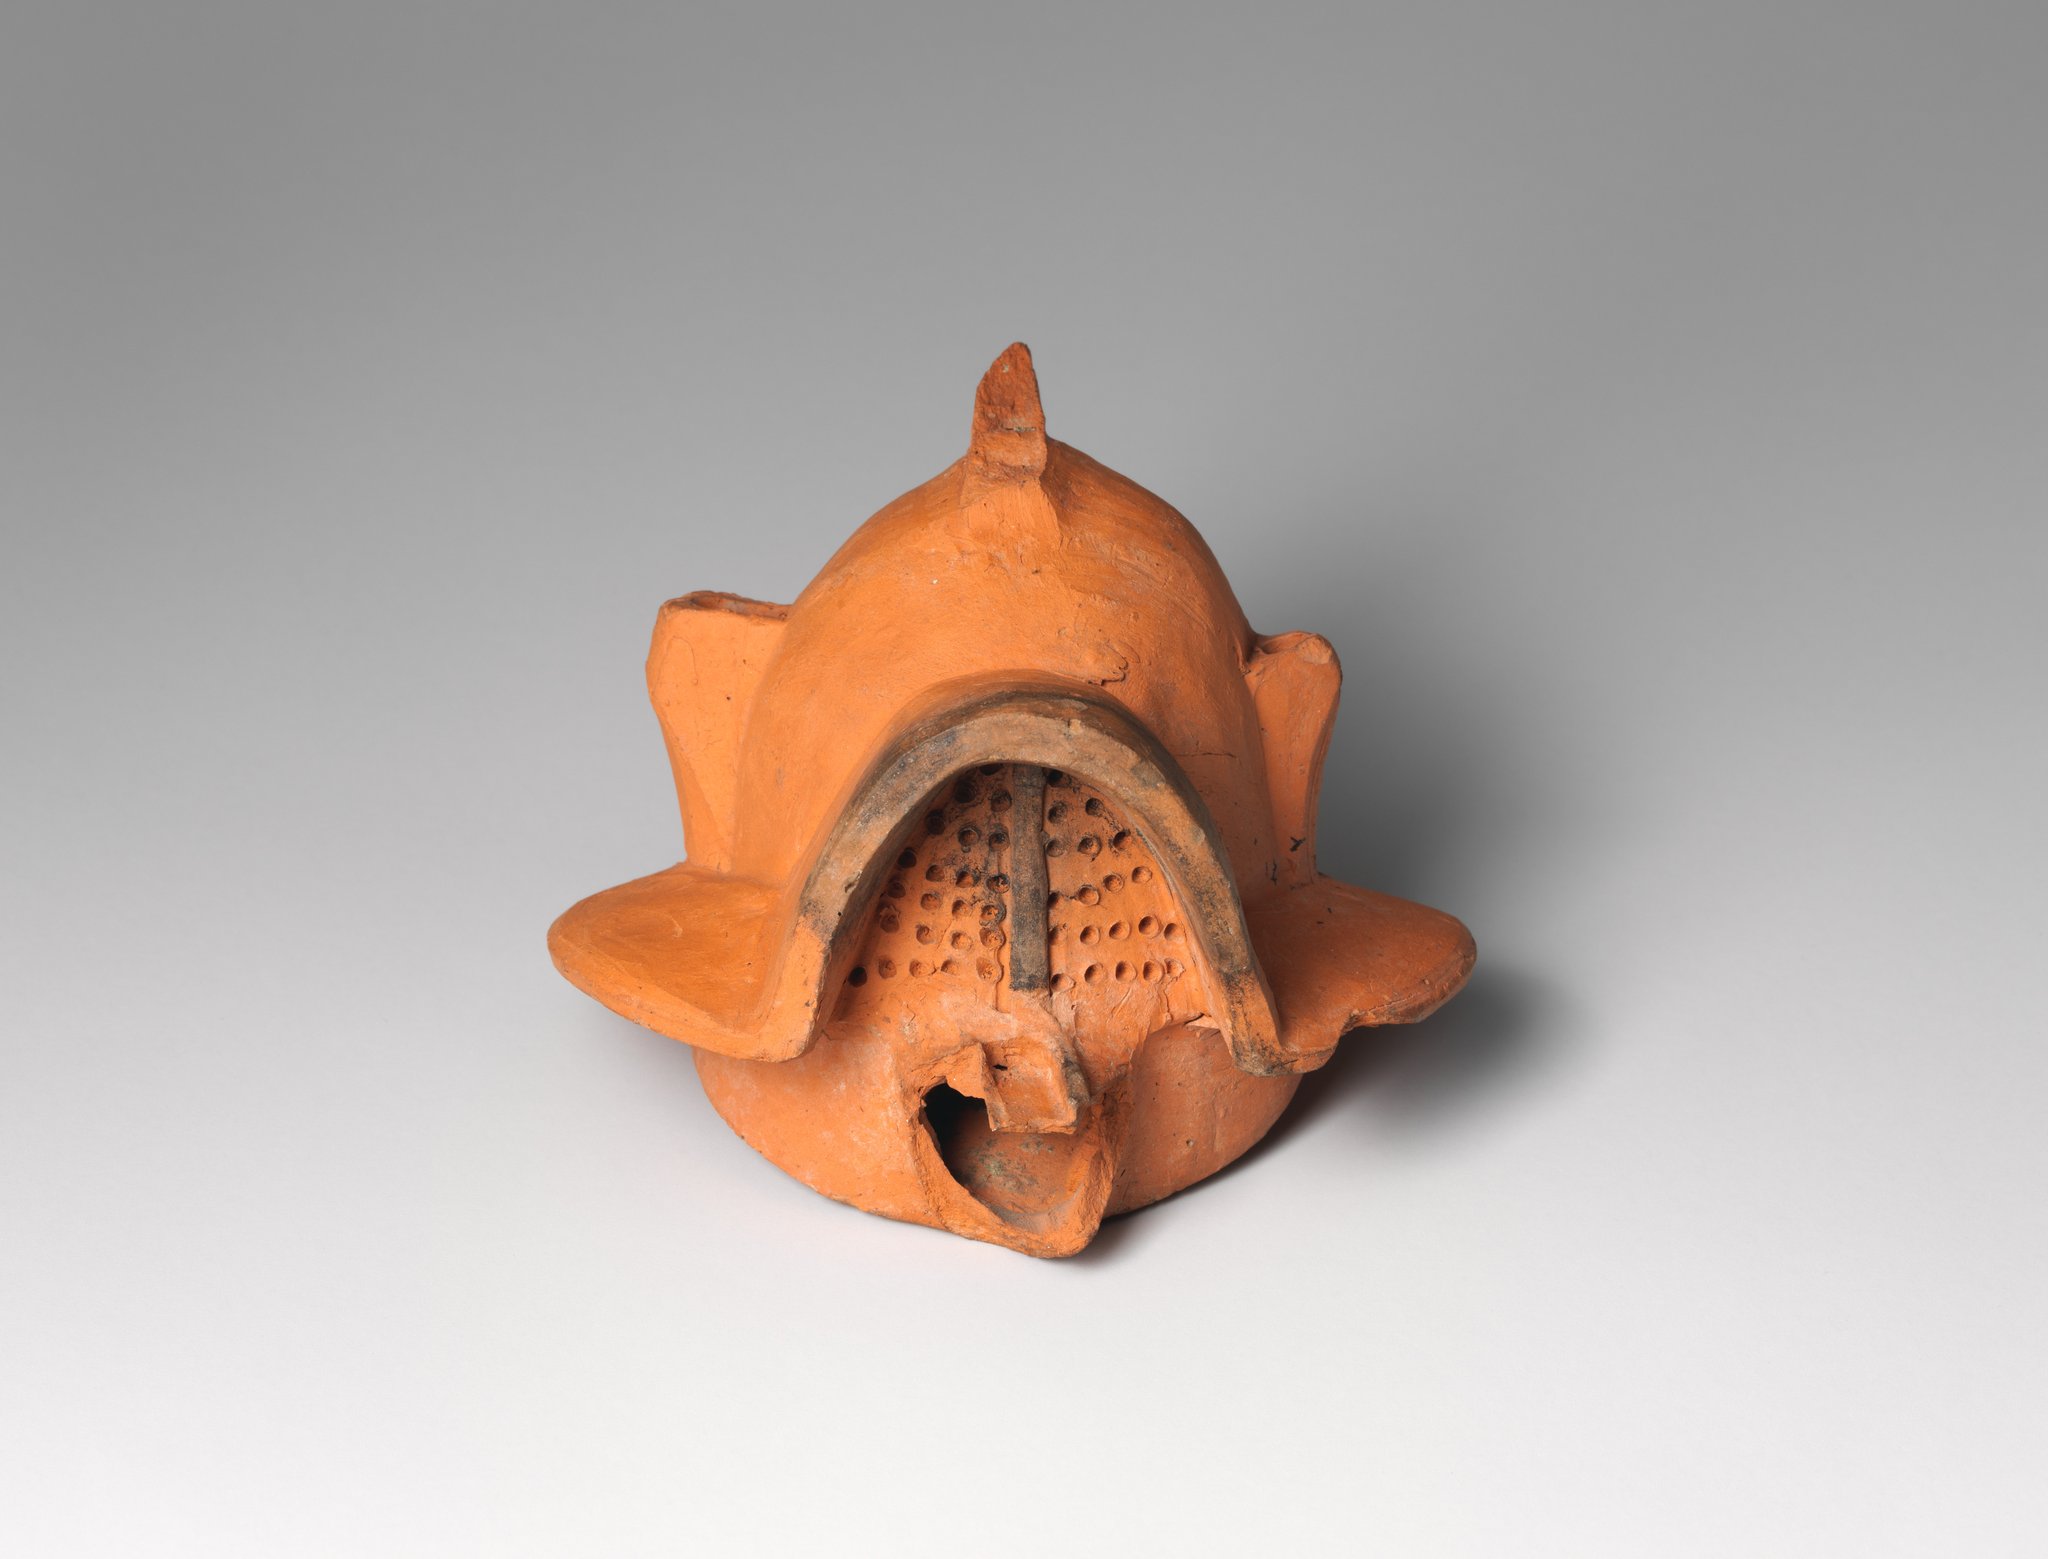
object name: lamp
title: Terracotta lamp in the form of a gladiator’s helmet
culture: roman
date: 101-150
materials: terracotta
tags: helmets